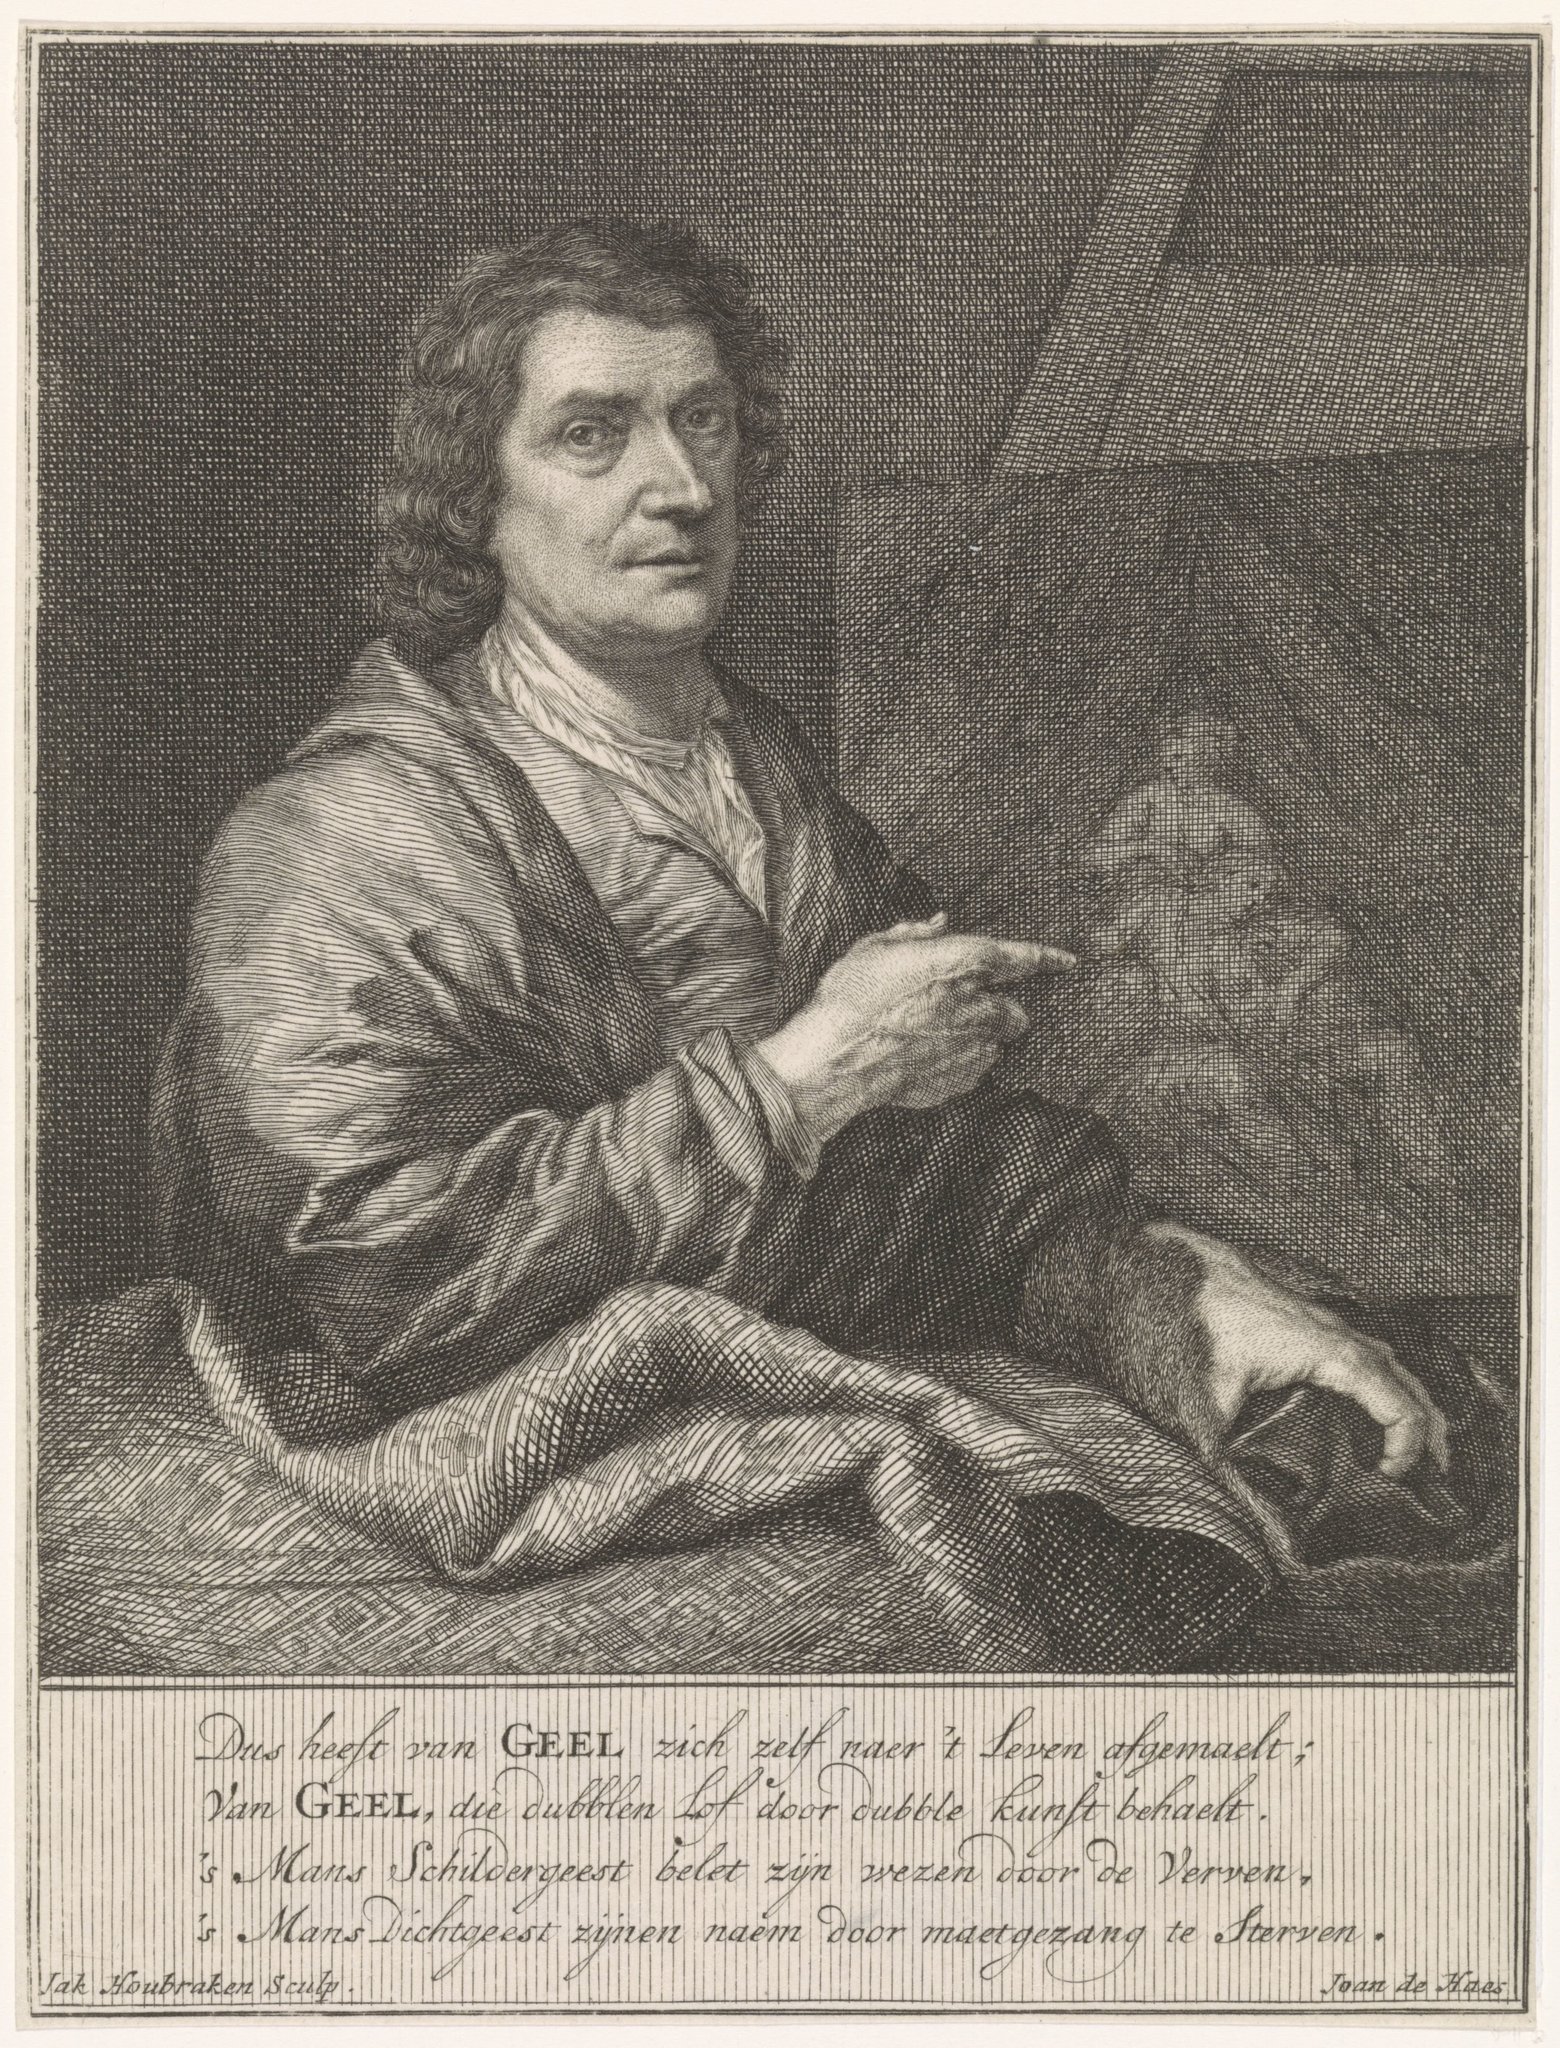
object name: print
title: Portret van Joost van Geel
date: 1708-1723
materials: paper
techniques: engraving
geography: amsterdam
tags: rotterdam, print maker, joost van geel, historical persons, portrait, self-portrait of painter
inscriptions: collector's mark: Lugt 2760, collector's mark: Lugt 2166, collector's mark: Lugt 2760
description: Portret ten halven lijve naar rechts van schilder Joost van Geel achter een tafel, wijzend op een schilderij op een ezel achter hem. Onder het portret een vierregelig vers in het Nederlands.